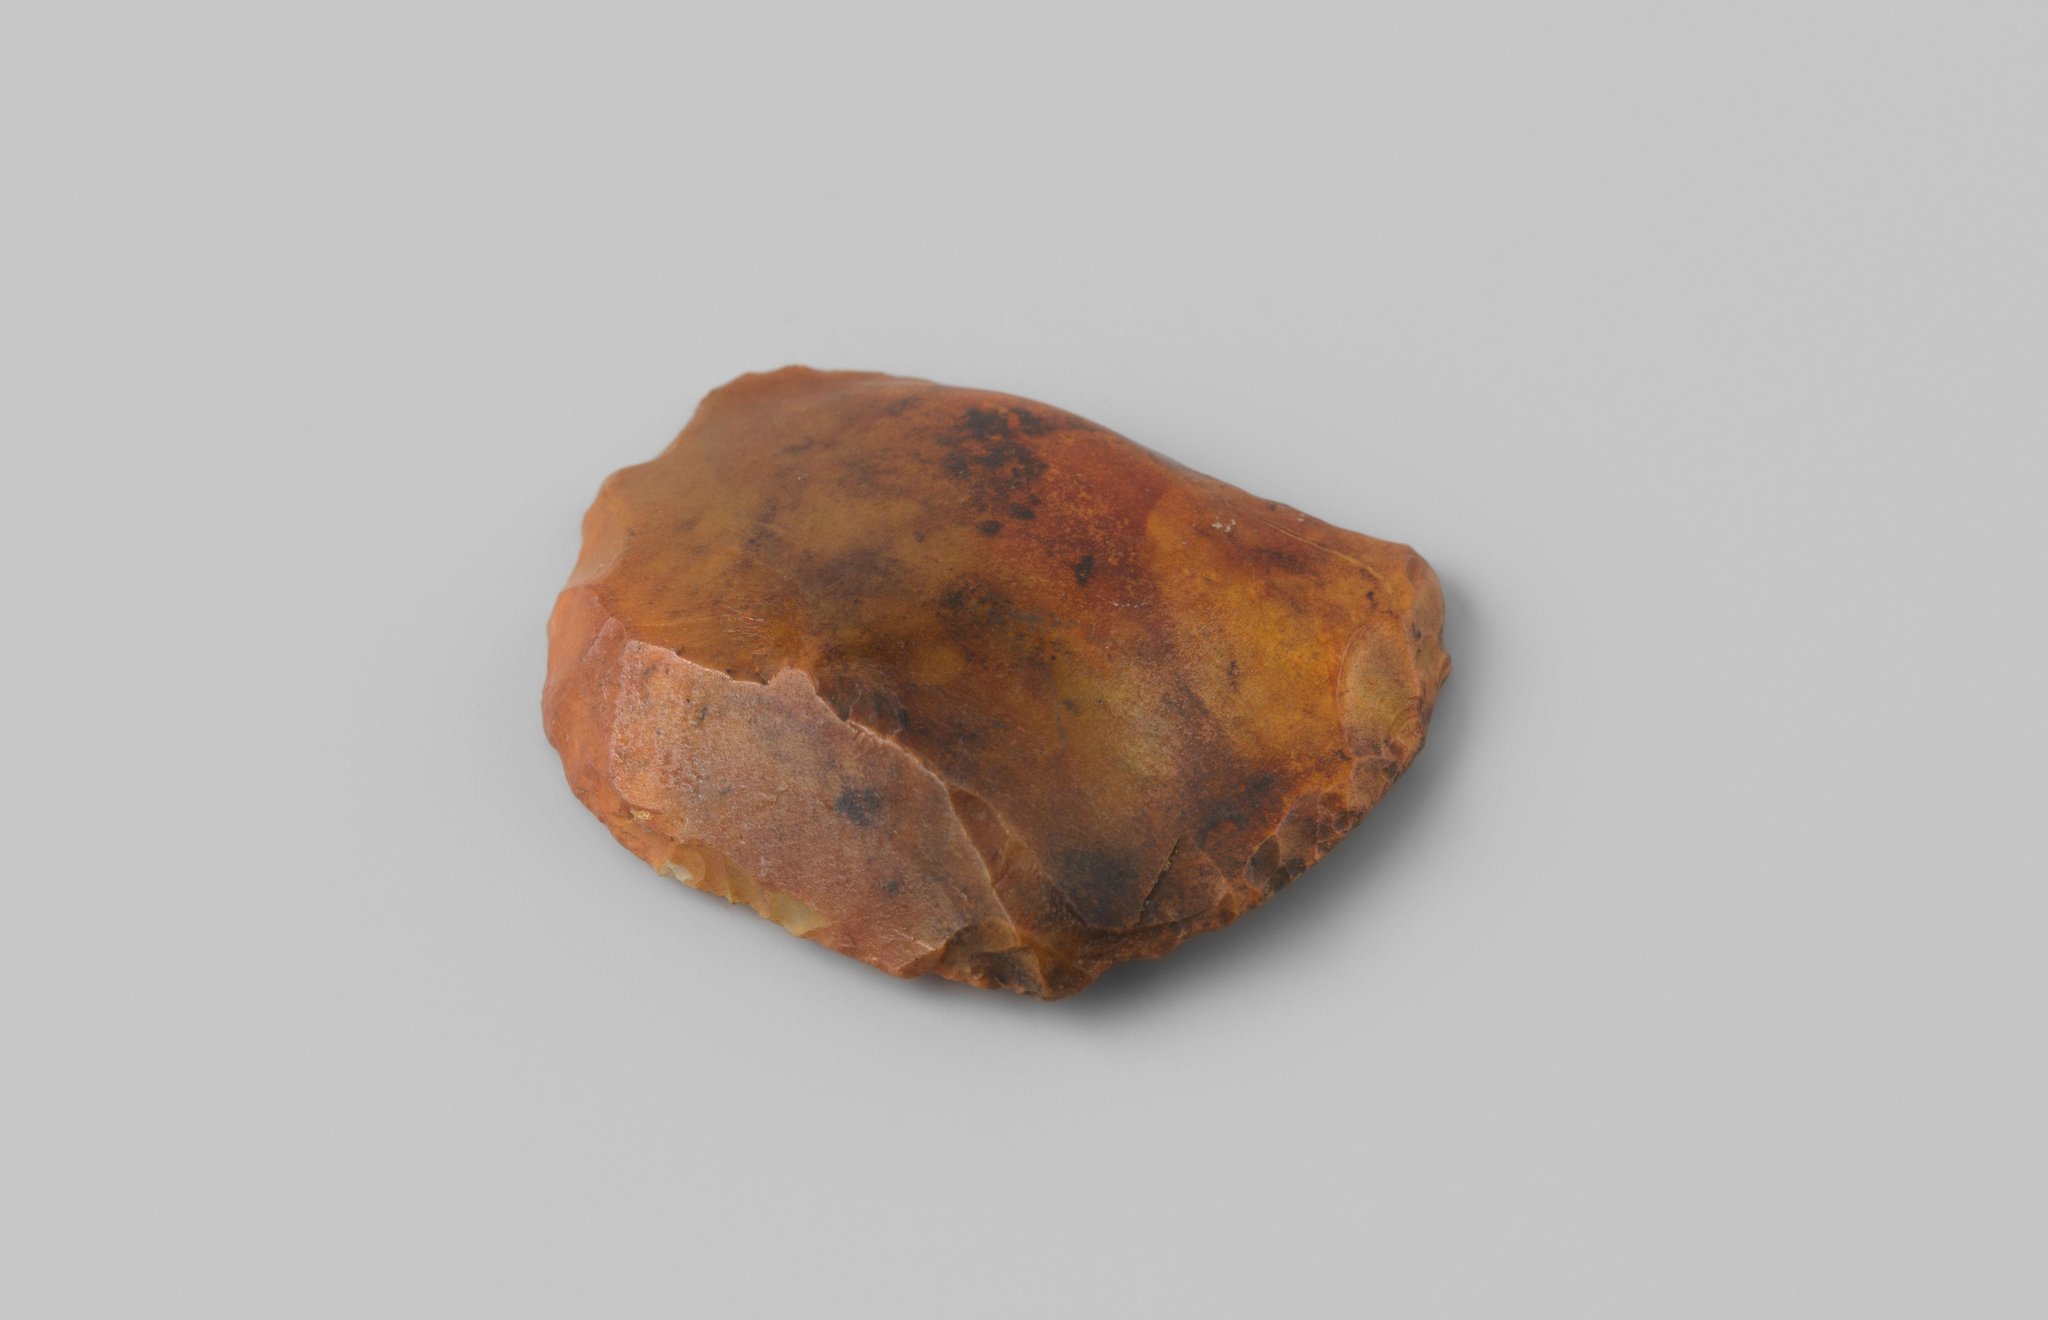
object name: gunflint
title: Vuursteen van een handwapen uit het wrak van de Oost-Indiëvaarder Hollandia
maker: Anonymous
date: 1700-1743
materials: stone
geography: netherlands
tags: verenigde oostindische compagnie, hollandia (schip), annet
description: Hand weapon, flint; sim. NG 1980-27H3128.